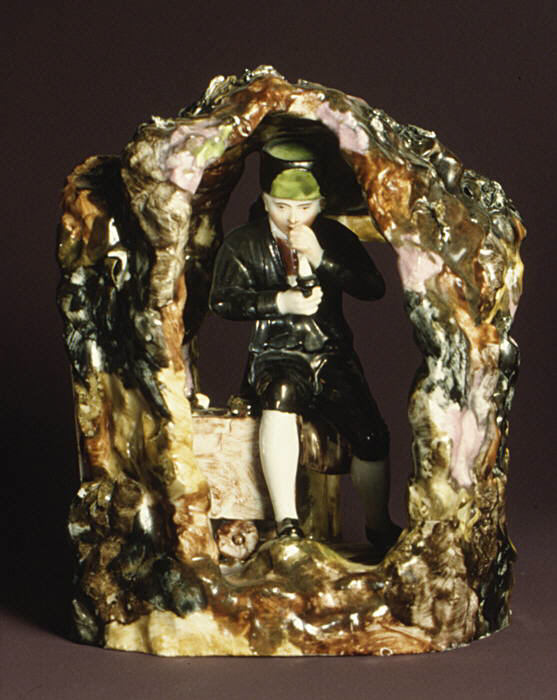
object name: figure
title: Miner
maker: royal porcelain manufactory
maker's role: factory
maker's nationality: danish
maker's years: 1775-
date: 1787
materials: hard paste porcelain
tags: men,flutes